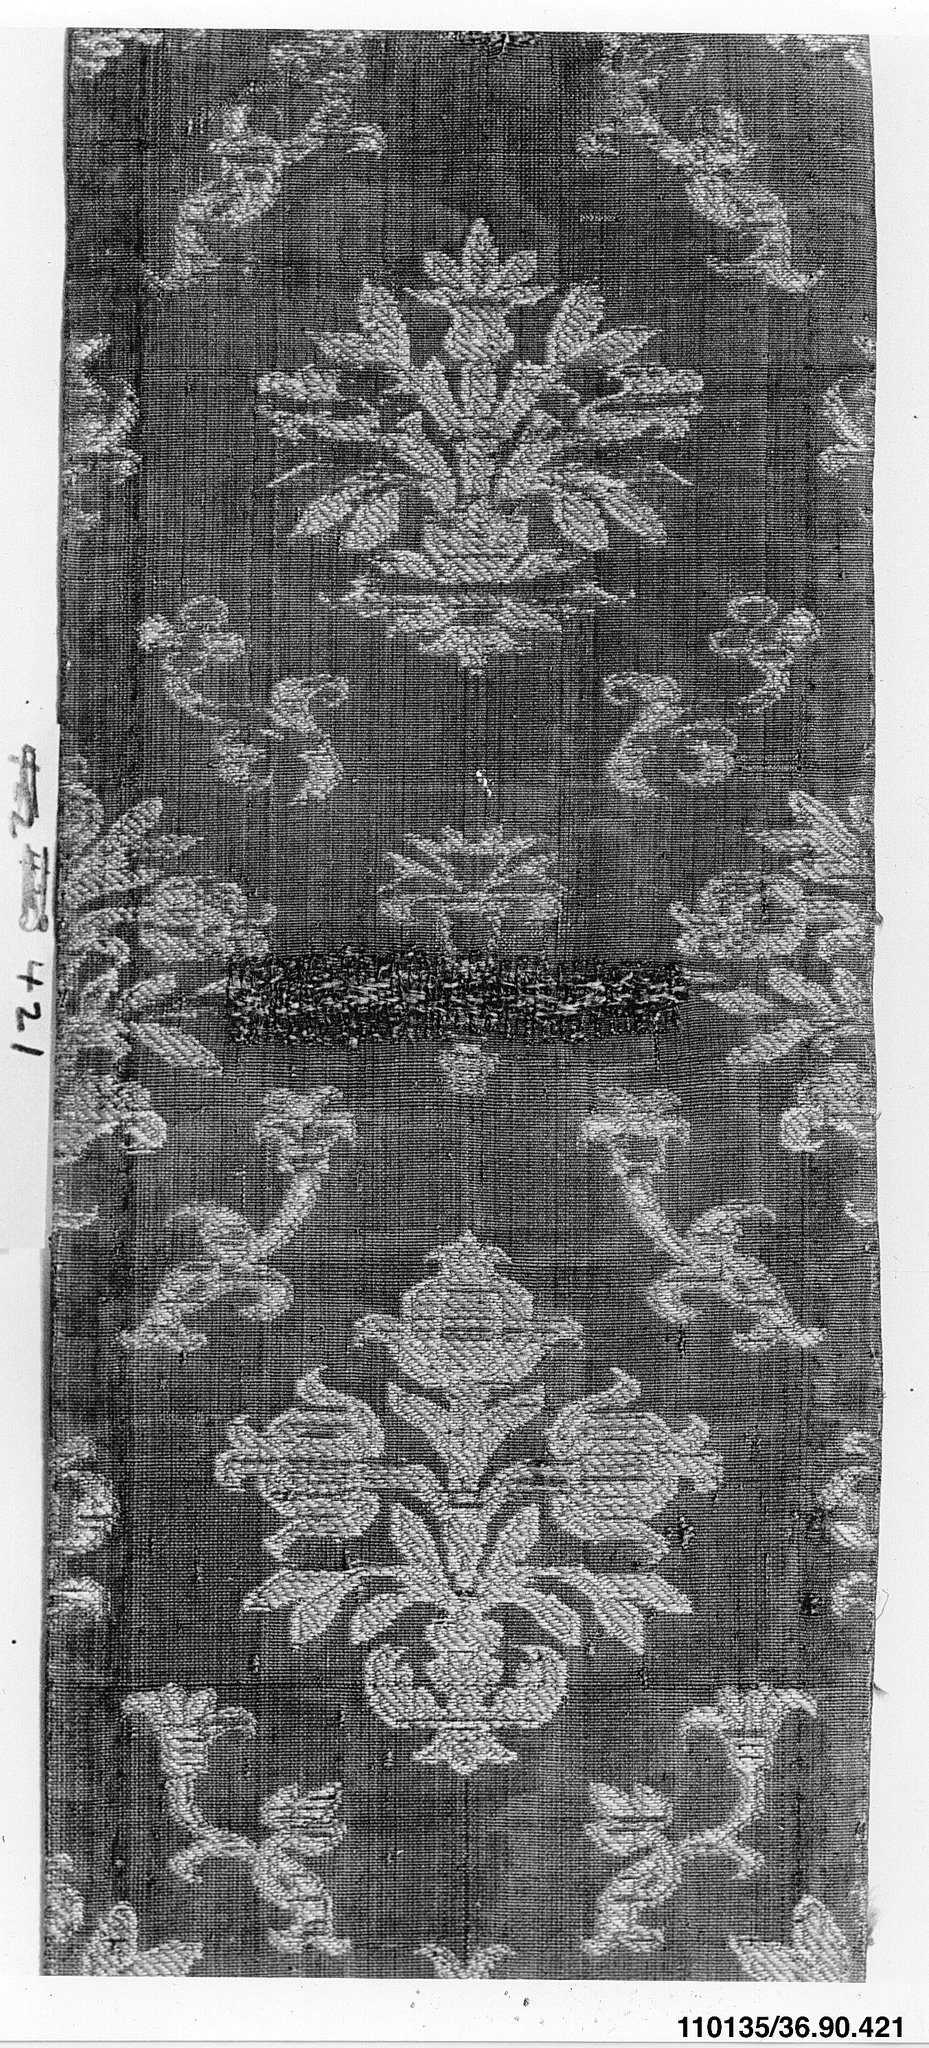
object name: piece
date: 1501-1700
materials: silk